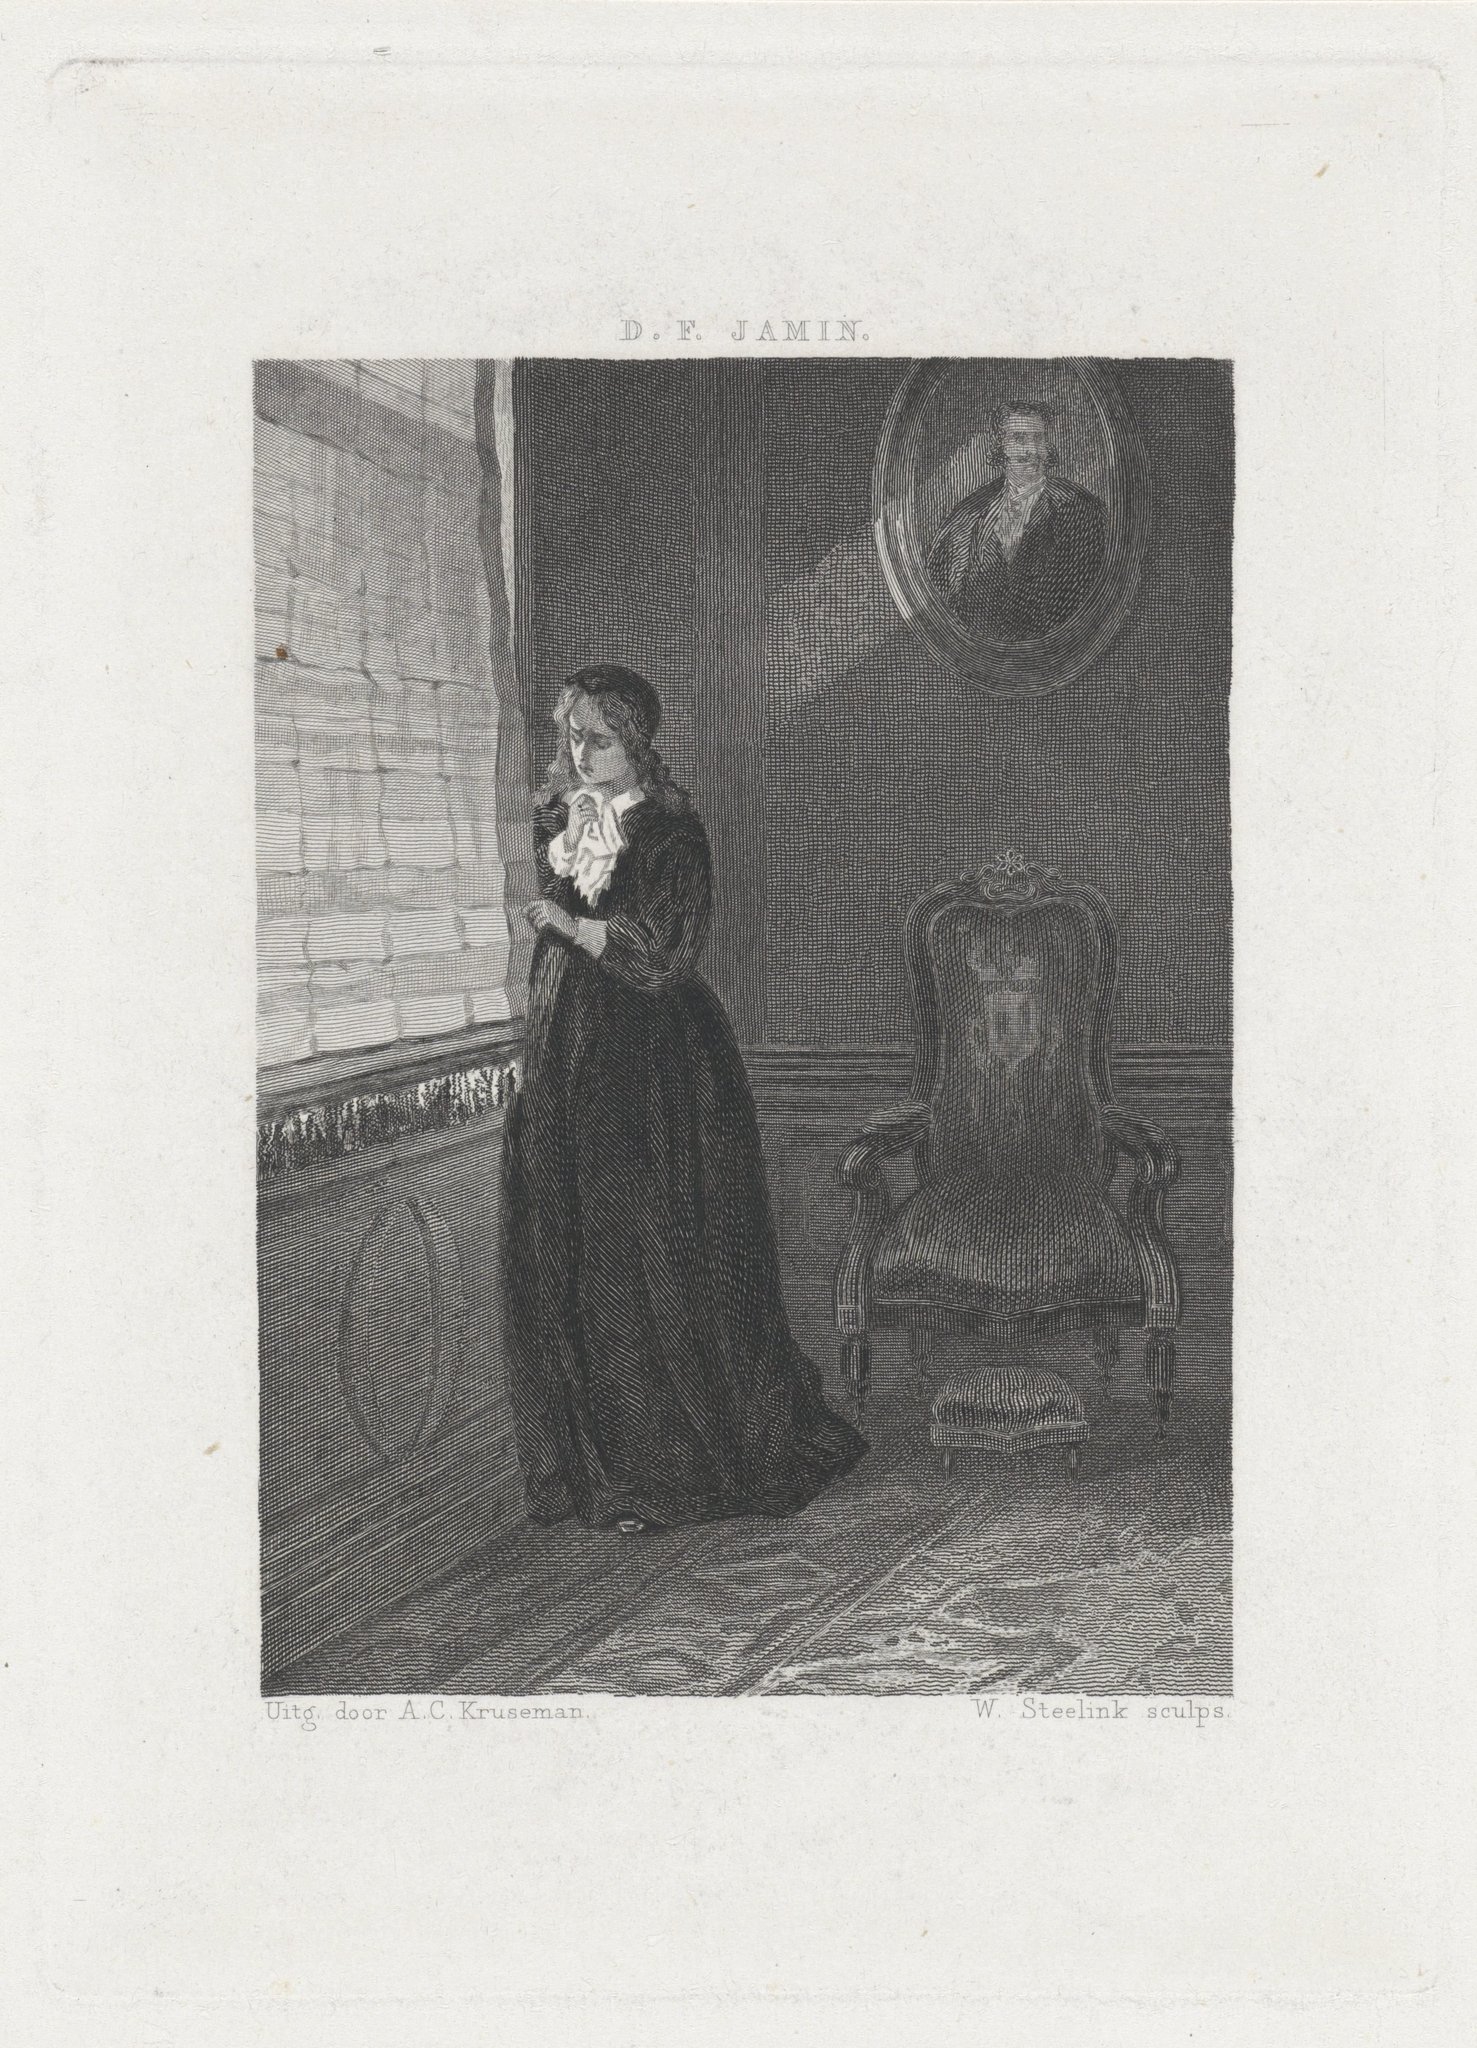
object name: book illustration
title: Huilende vrouw kijkt door een kier van het gordijn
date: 1865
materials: paper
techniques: etching, engraving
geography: haarlem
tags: view through a window from the inside, weeping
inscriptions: collector's mark: Lugt 2228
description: Een huilende vrouw, met zakdoek in de hand, kijkt langs het gordijn naar buiten. Aan de muur het portret van een man en daaronder een stoel.